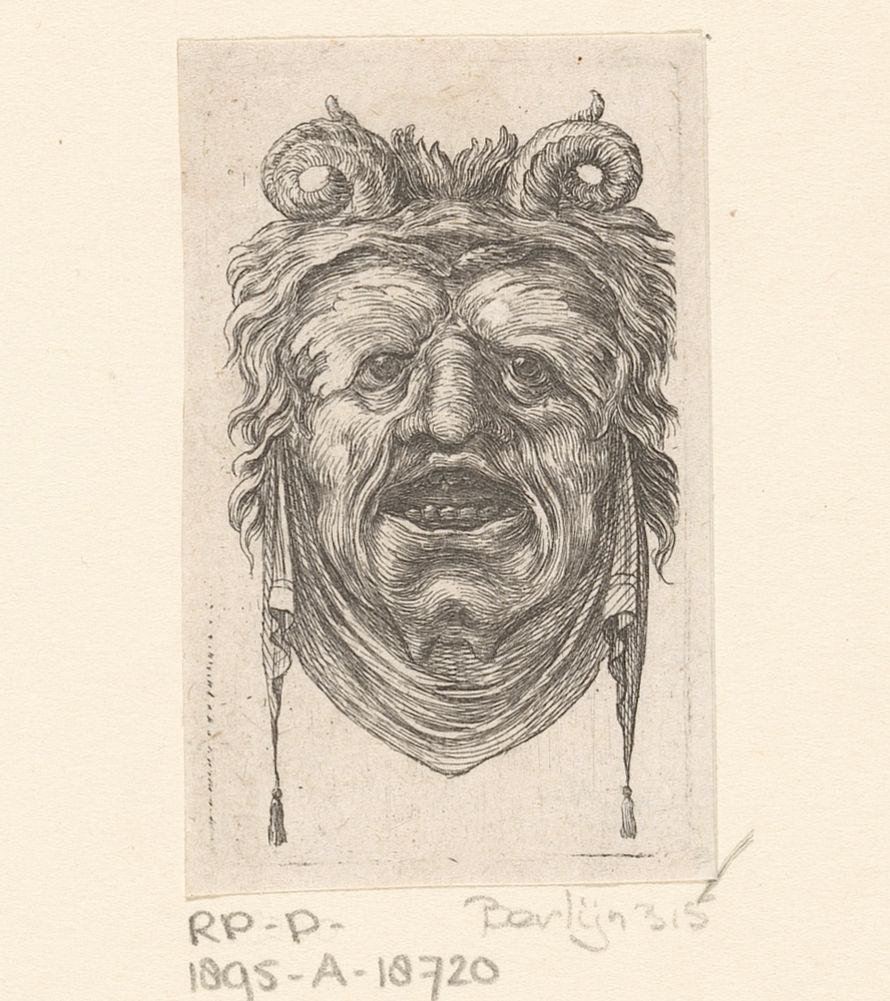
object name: print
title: Masker met ramshoorns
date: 1626-1676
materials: paper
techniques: etching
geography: paris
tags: mask, mascaron ~ ornament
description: Prent is onderdeel van een serie van achttien.